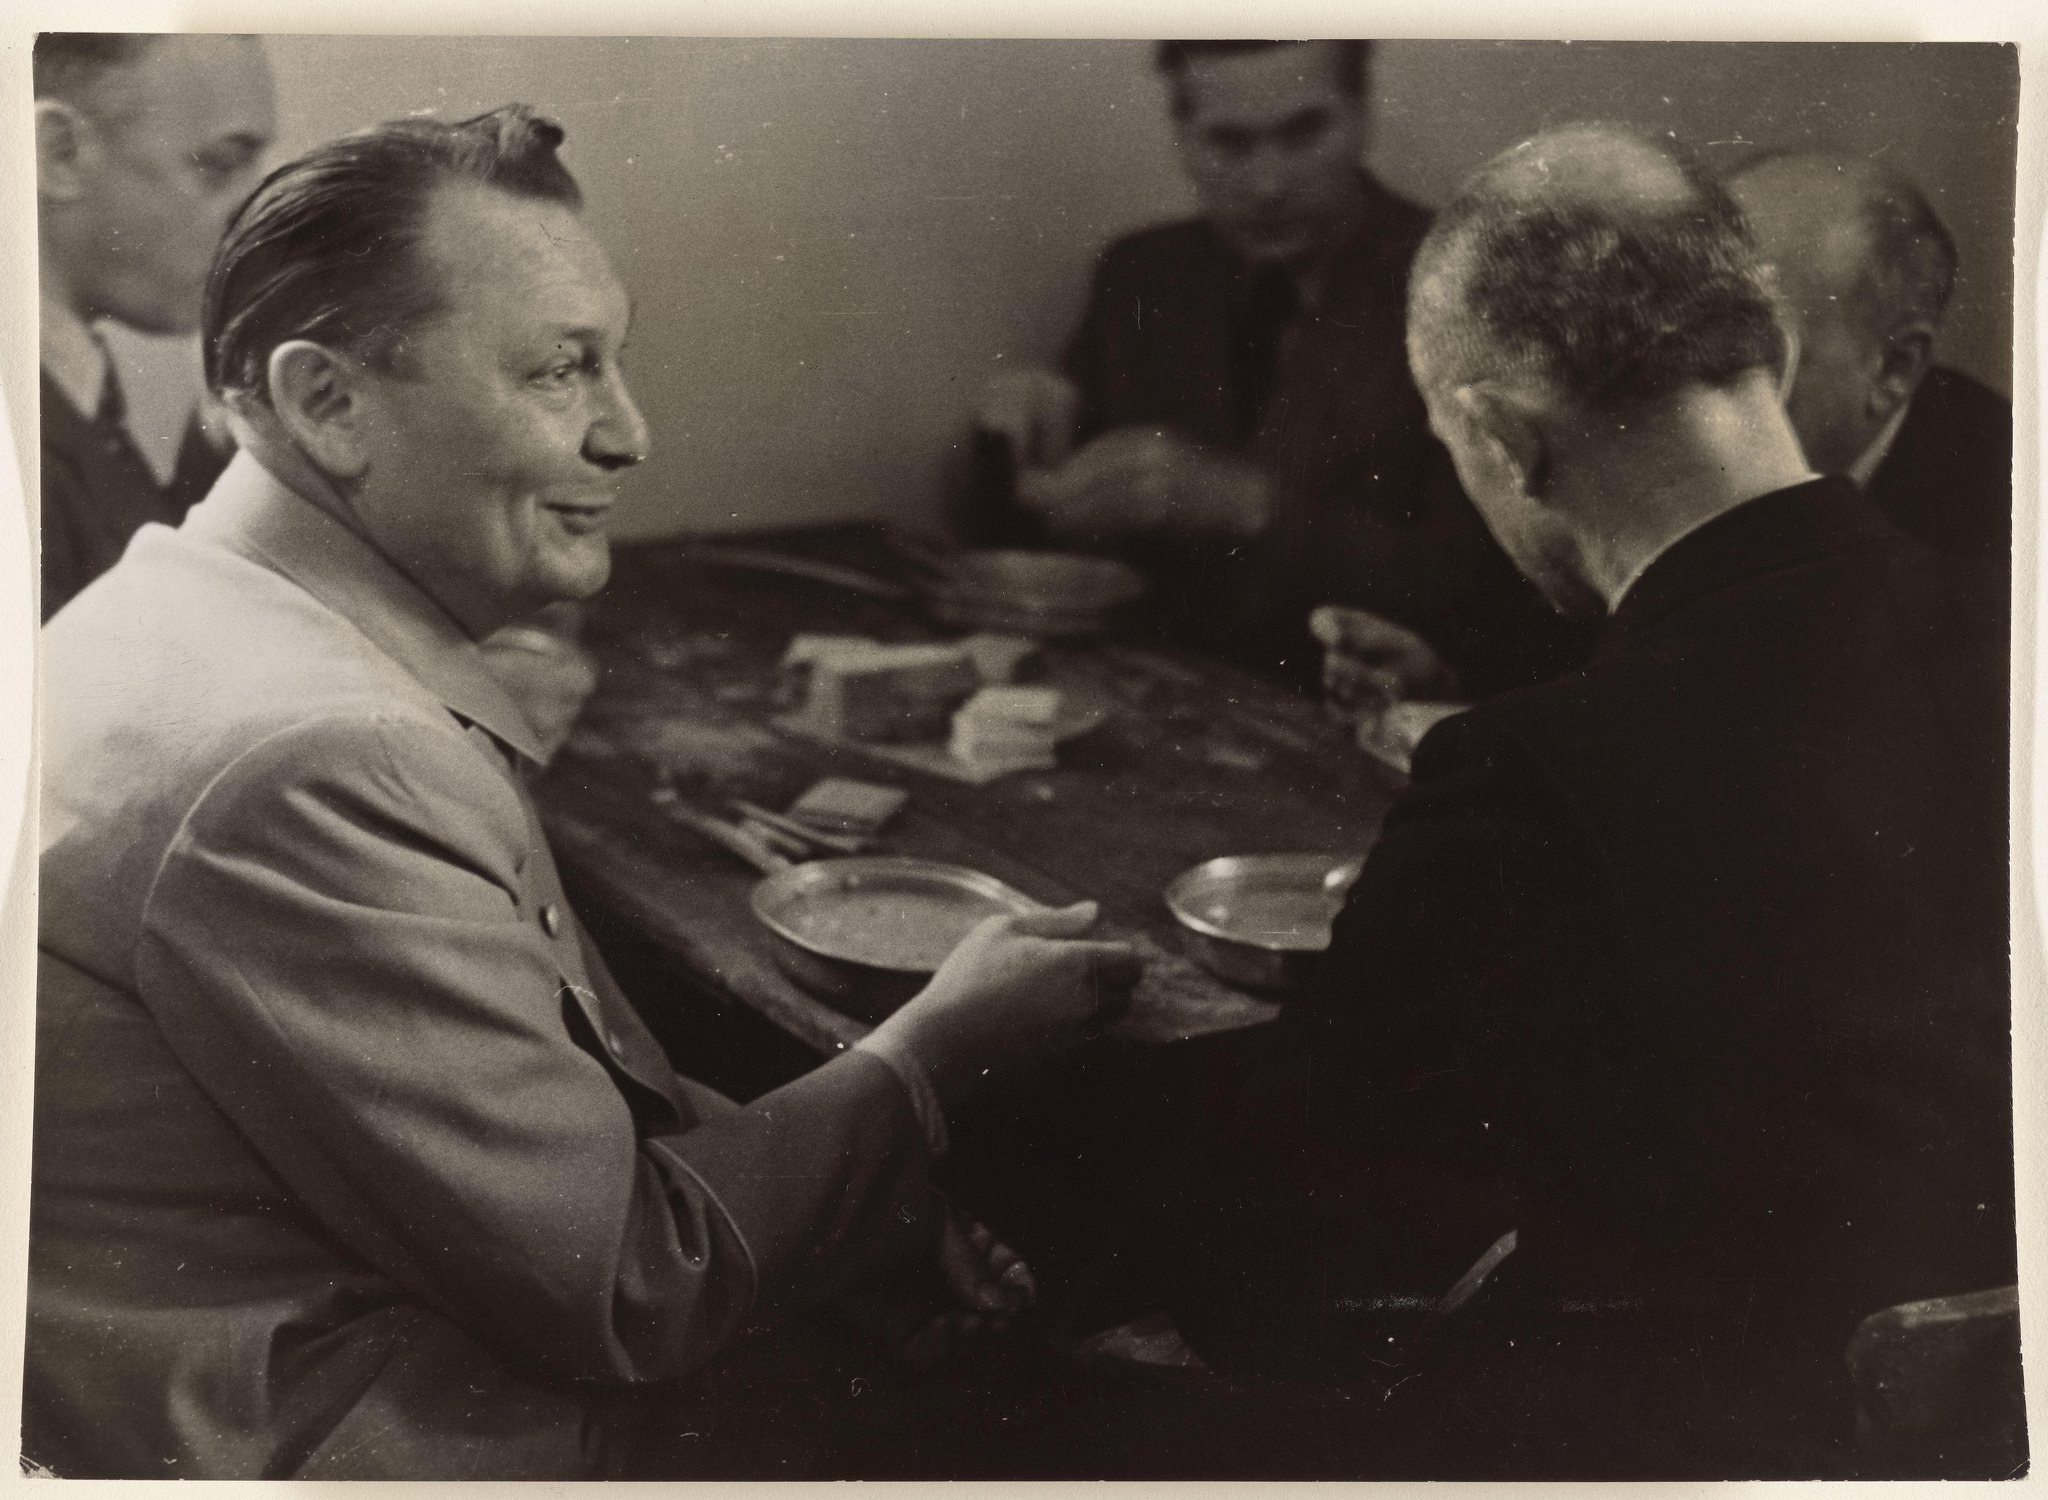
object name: photograph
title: Proces van Neurenberg: Göring en Von Ribbentrop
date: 1945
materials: photographic support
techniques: photography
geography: nuremberg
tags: politician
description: Göring en Von Ribbentrop aan de lunch in de gevangenis tijdens het proces van Neurenberg.